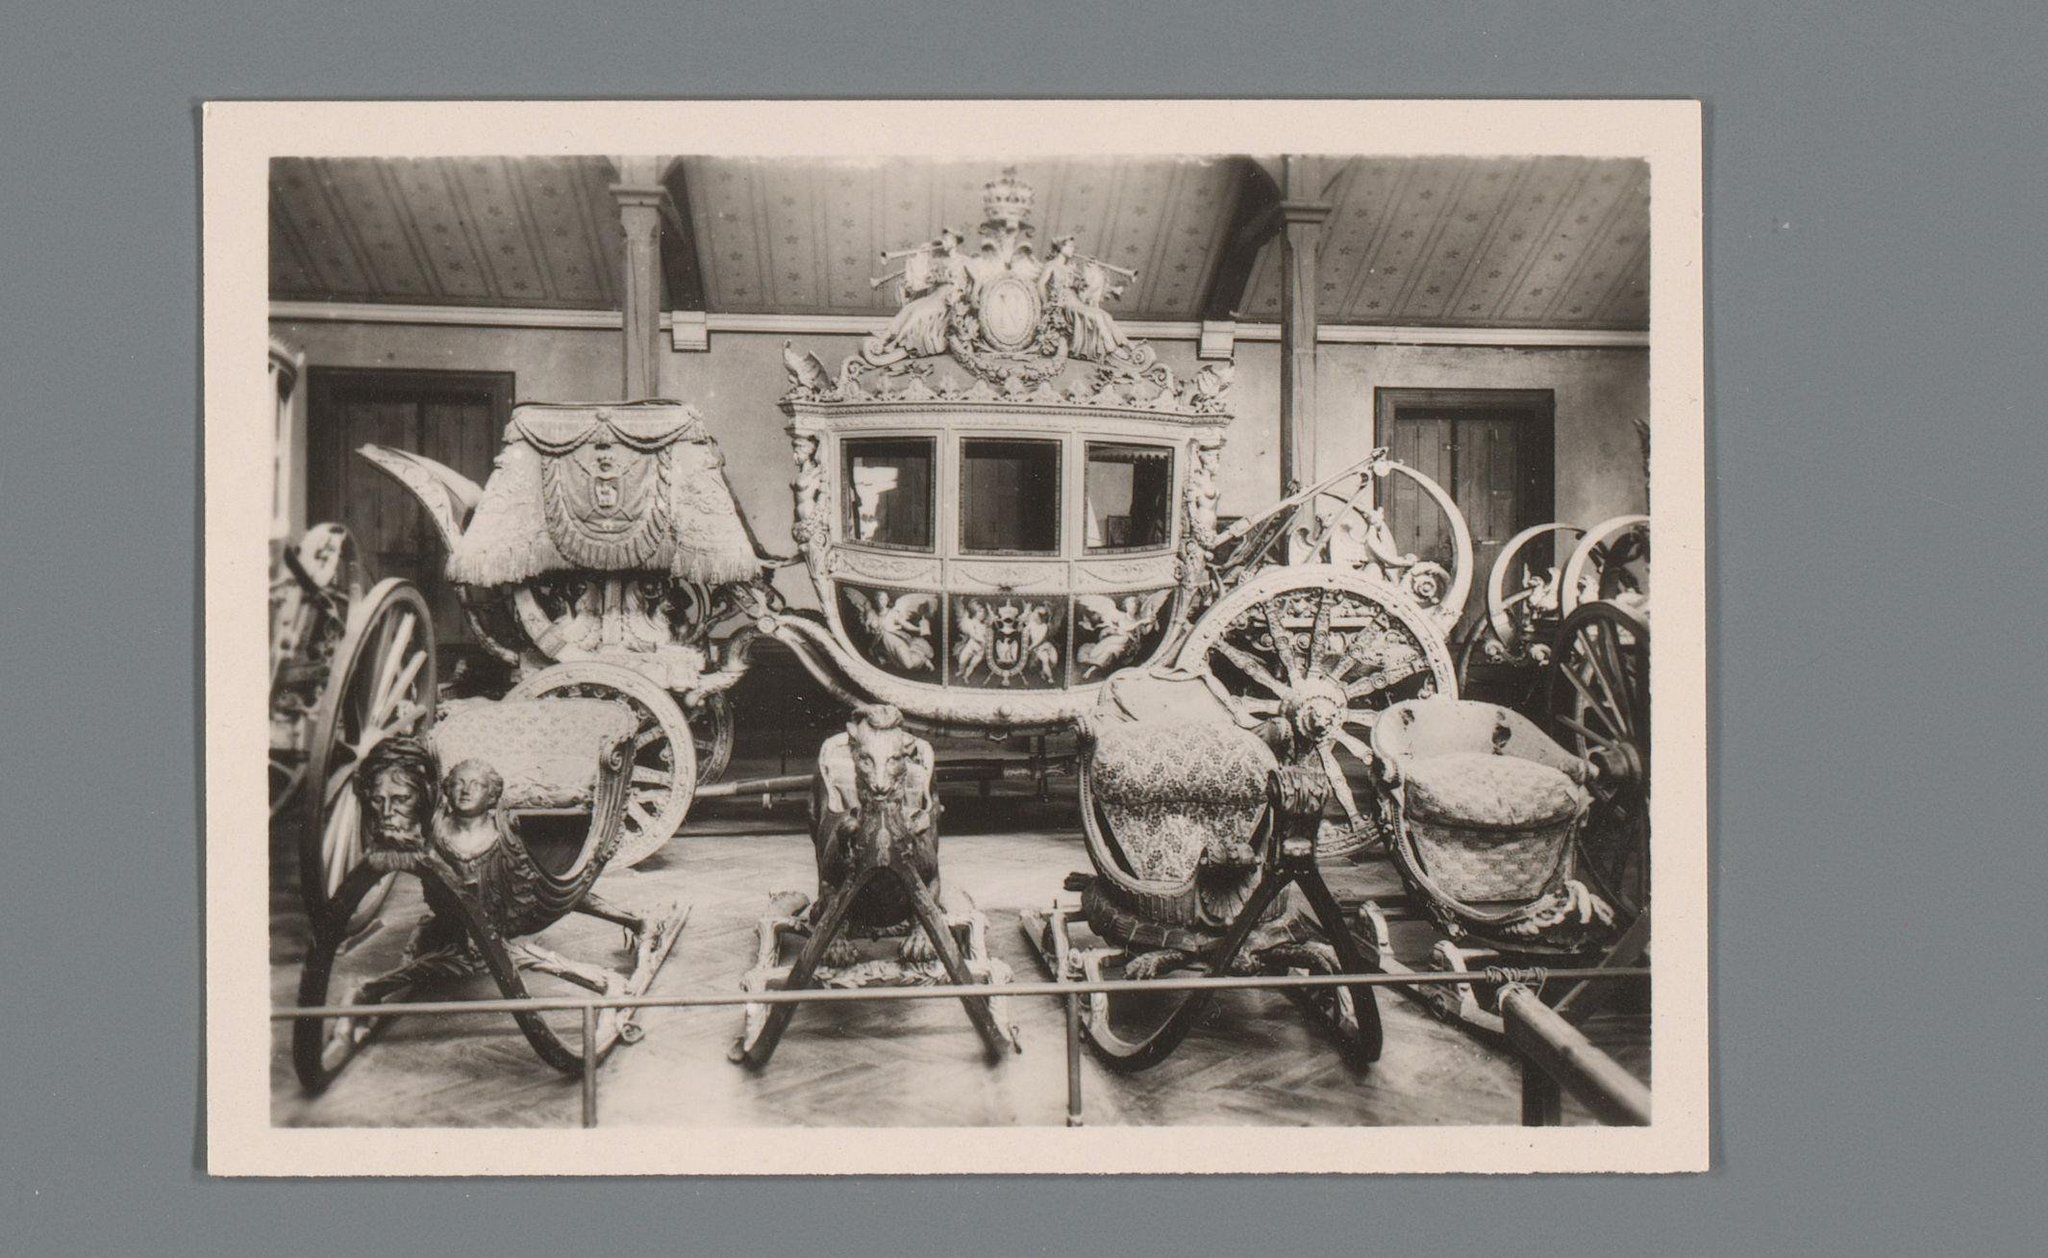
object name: photograph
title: Musée des Voitures - Carrosse du Sacre de Charles X / The collection of carriages - Carriage used for the coronation of Charles X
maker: Anonymous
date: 1900-1920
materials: paper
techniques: gelatin silver print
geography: versailles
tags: passenger carriage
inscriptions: number: ‘20’